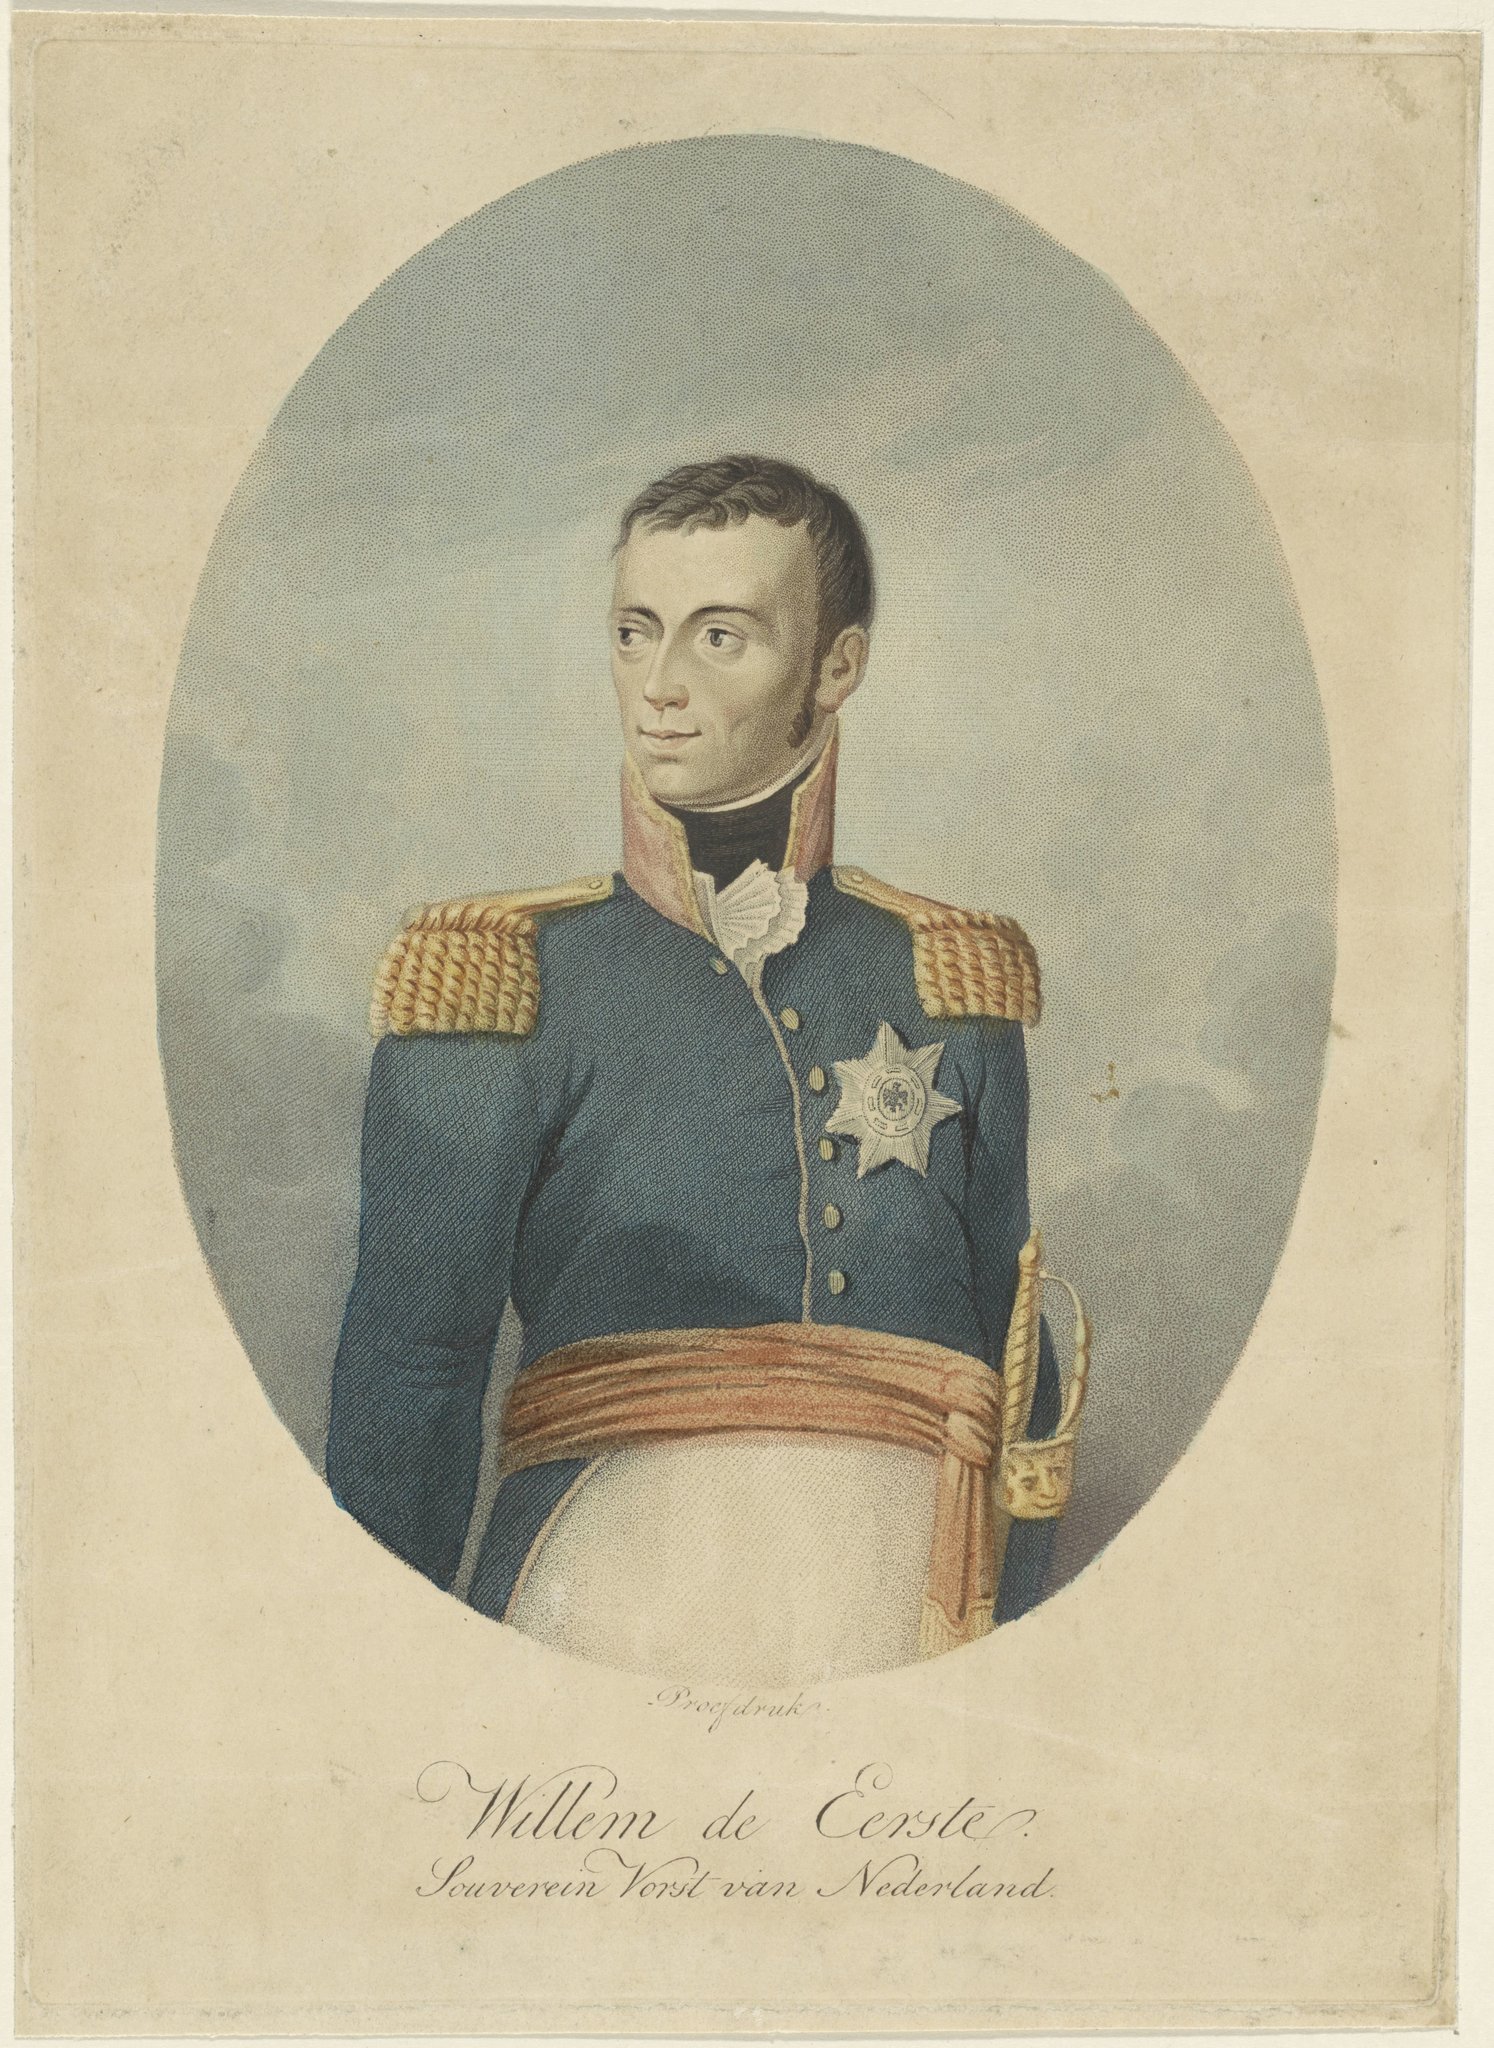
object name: print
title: Portret van Willem I Frederik, koning der Nederlanden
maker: Anonymous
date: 1813-1815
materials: paper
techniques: engraving, etching, hand coloring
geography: netherlands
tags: the hague, berlin, william i of the netherlands, knighthood order (with name) - insignia of a knighthood order, e.g.: badge, chain (with name of order)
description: De hier vermelde titel verwijst naar de hoogst verkregen titel van de geportretteerde, niet per se naar de titel die de geportretteerde op deze voorstelling draagt.